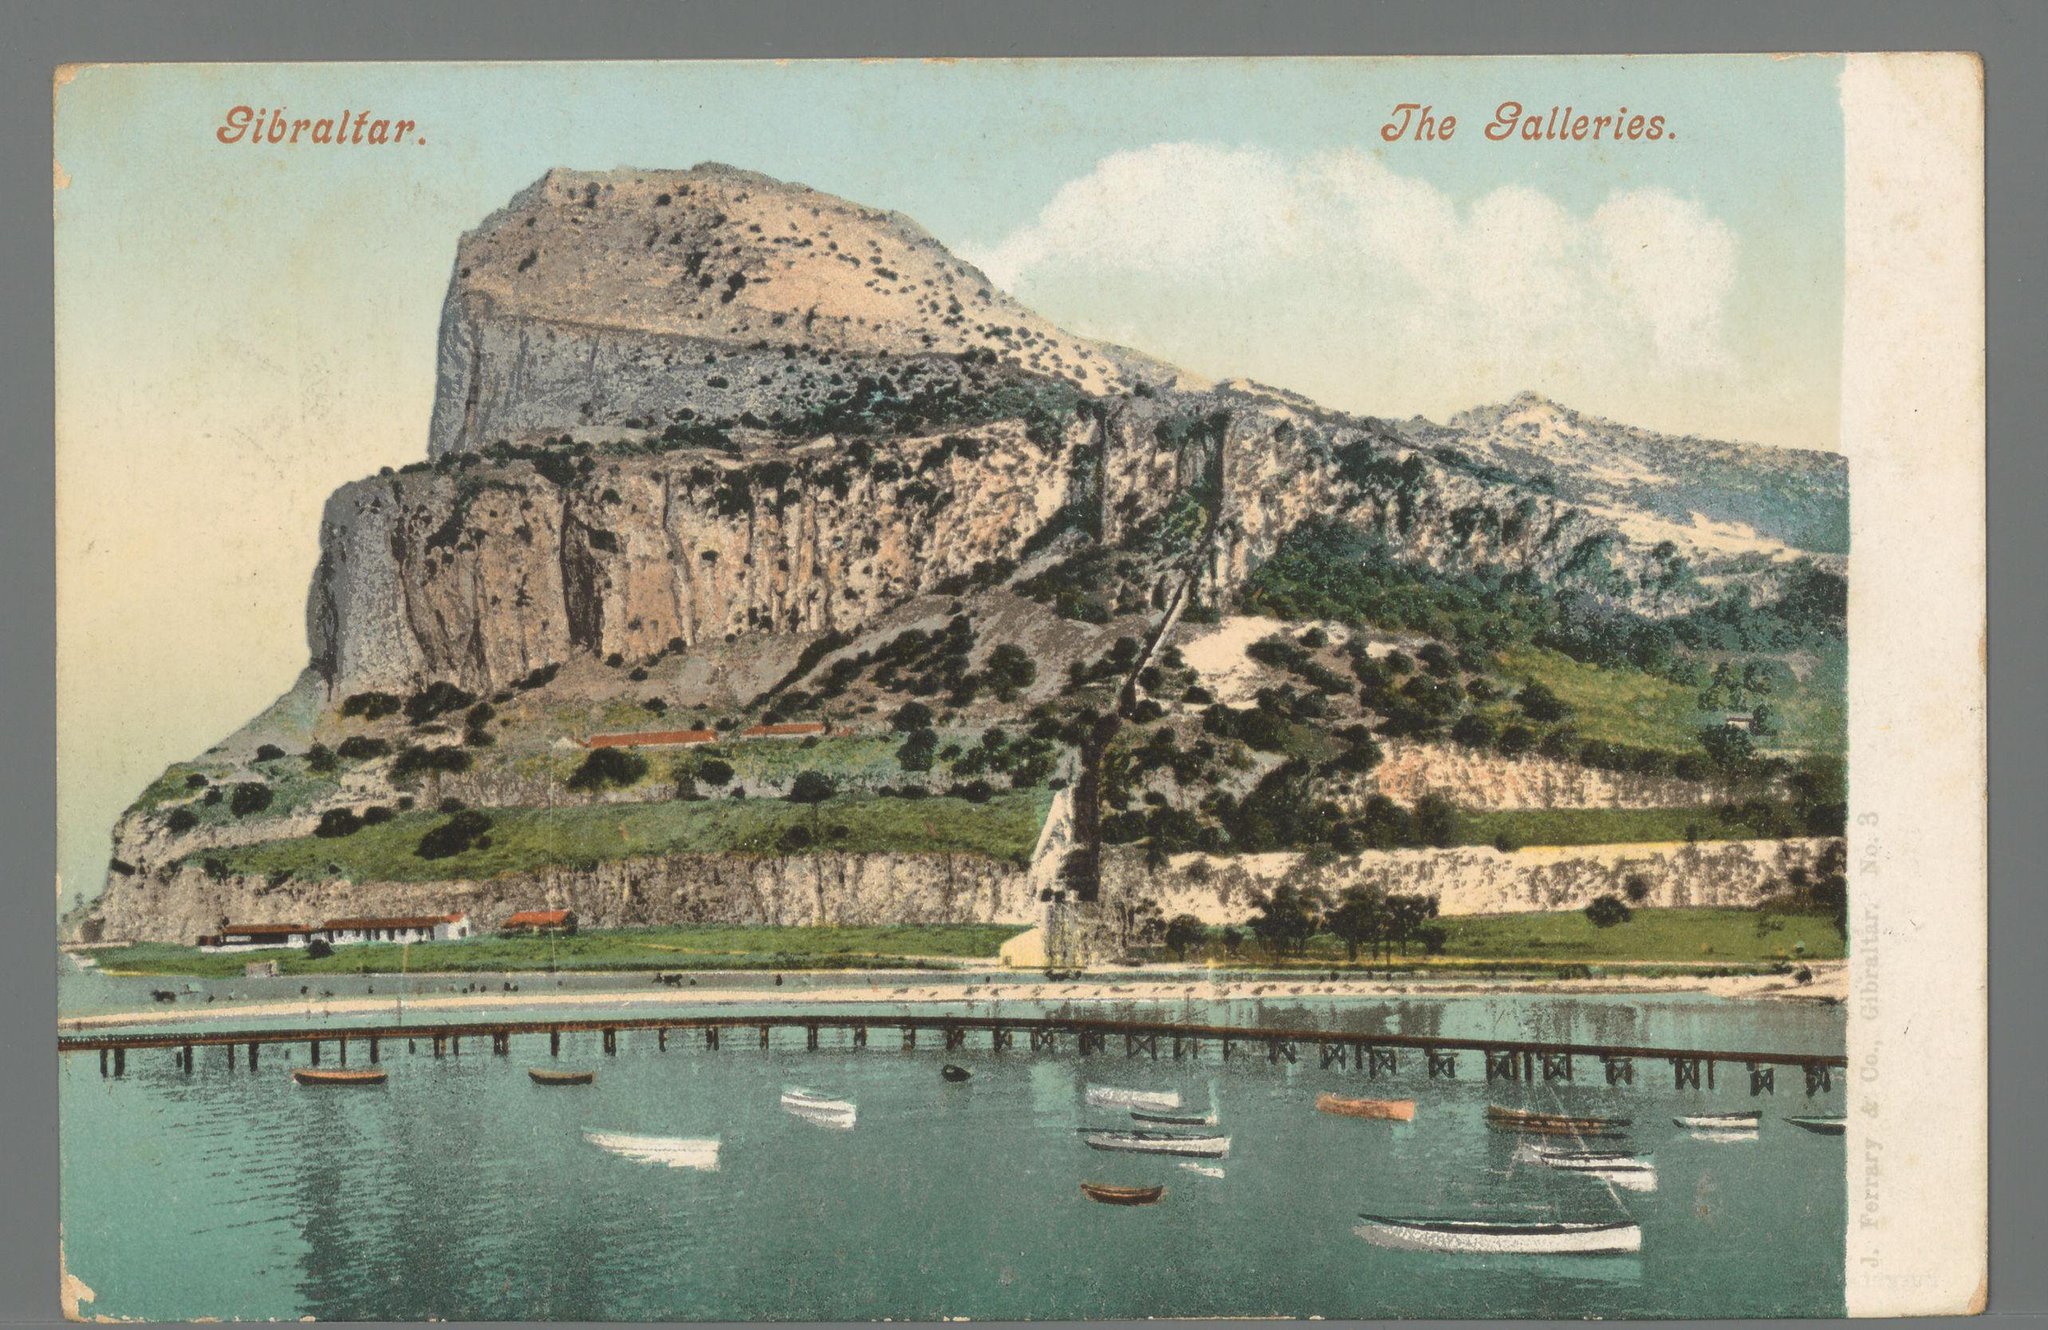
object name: photomechanical print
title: Gibraltar. The Galleries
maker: Anonymous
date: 1890-1906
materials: cardboard, photographic process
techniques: writing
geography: gibraltar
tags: rocks, sea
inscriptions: poststempel, verso, gestempeld